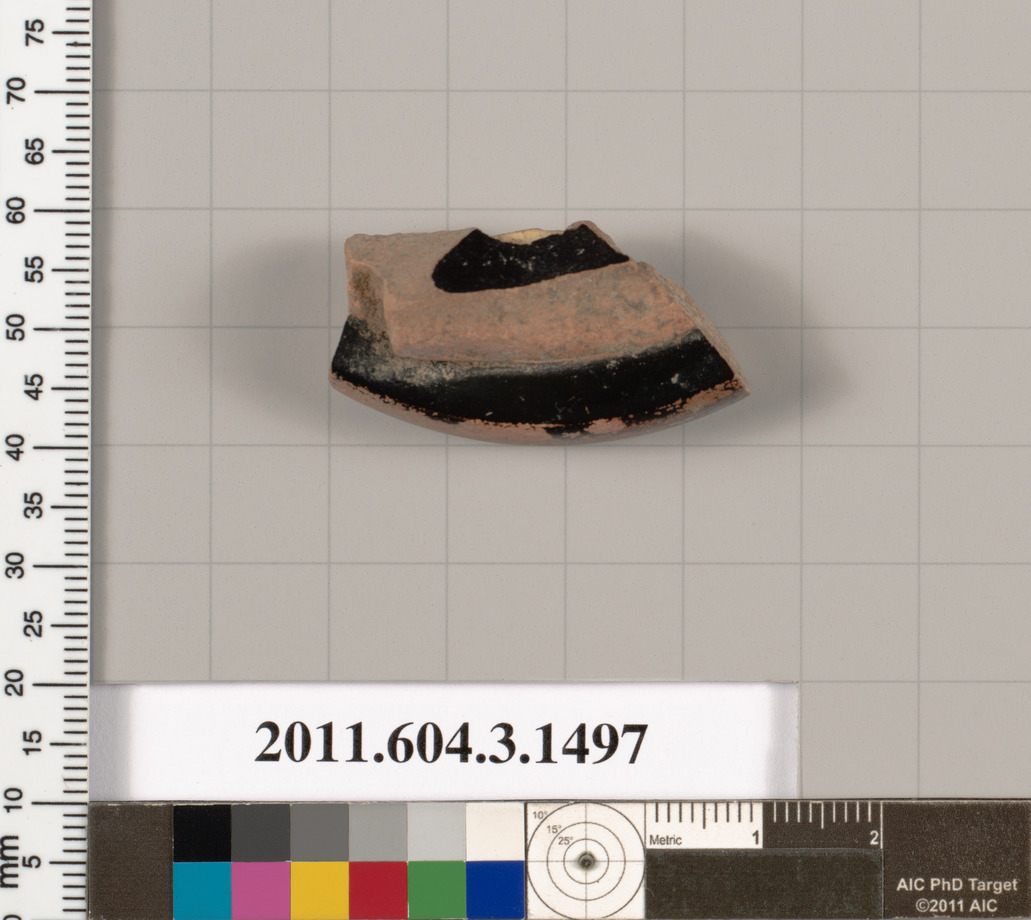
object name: skyphos fragment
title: Terracotta fragment of a skyphos (deep drinking cup)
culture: greek, attic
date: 600-401 BCE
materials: terracotta